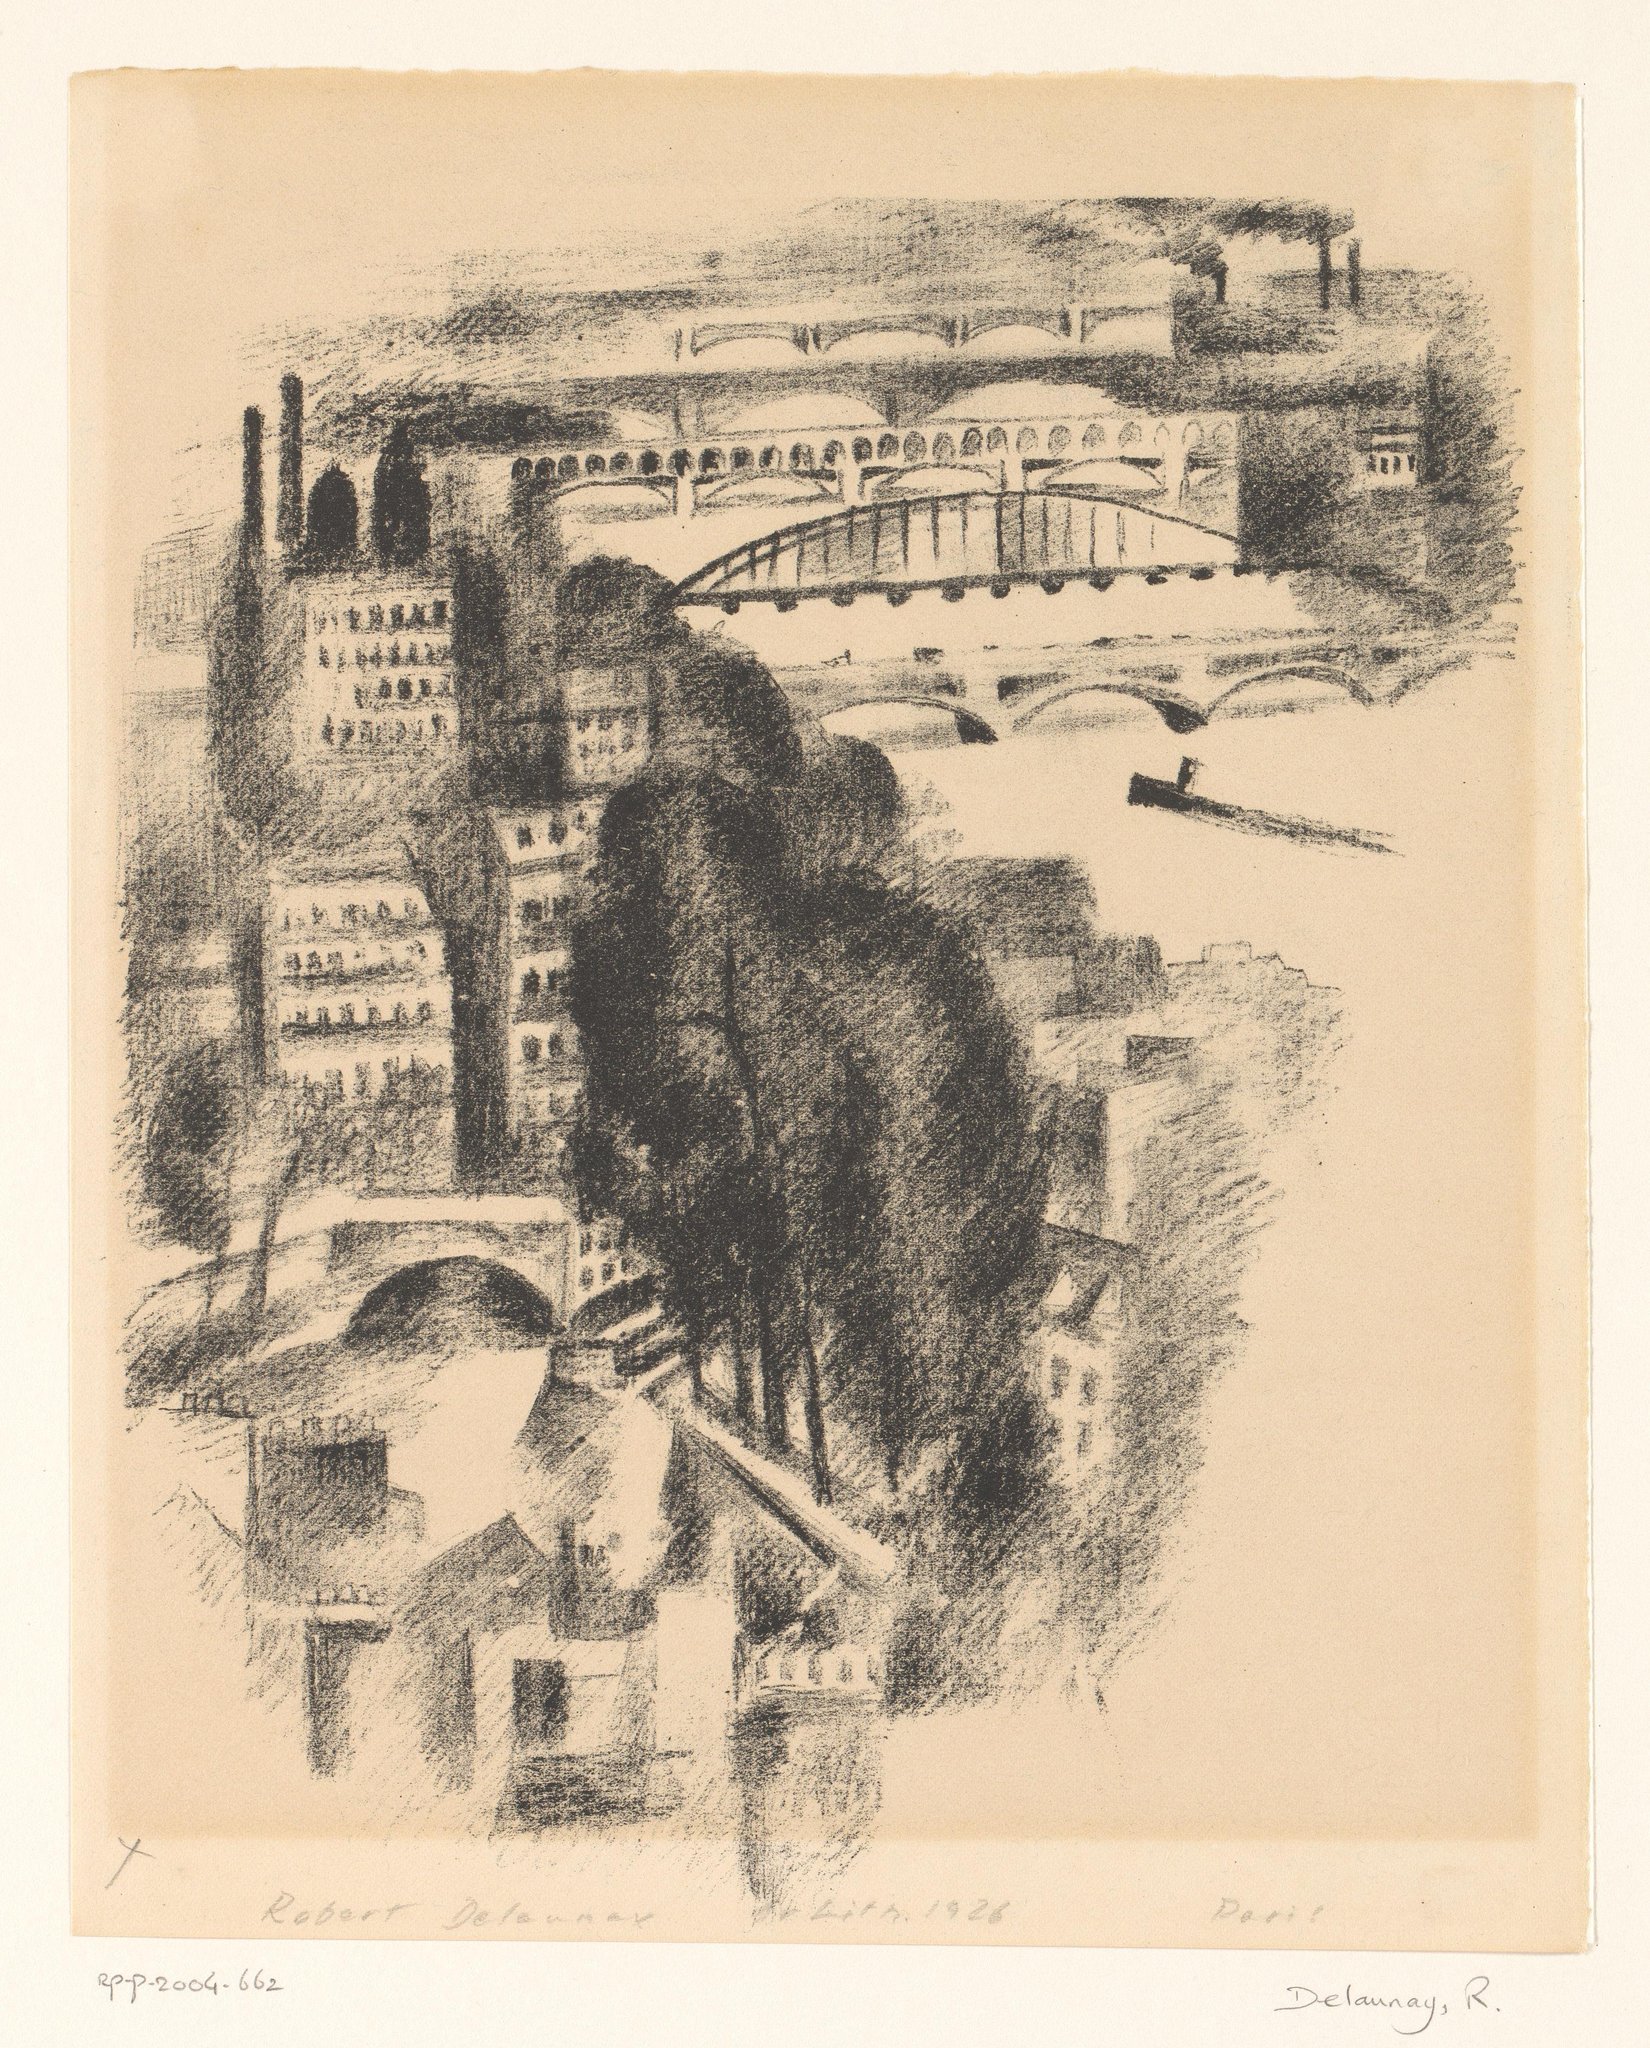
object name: print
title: Gezicht op Parijs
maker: robert delaunay (1885-1941)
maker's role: print maker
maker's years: 1885-1941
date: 1926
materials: paper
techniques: lithograph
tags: city-view in general; 'veduta', bridge in city across river, canal, etc., paris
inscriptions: annotation: ‘Robert Delaunay Lith. 1926 Paris’, collector's mark: Lugt 2228